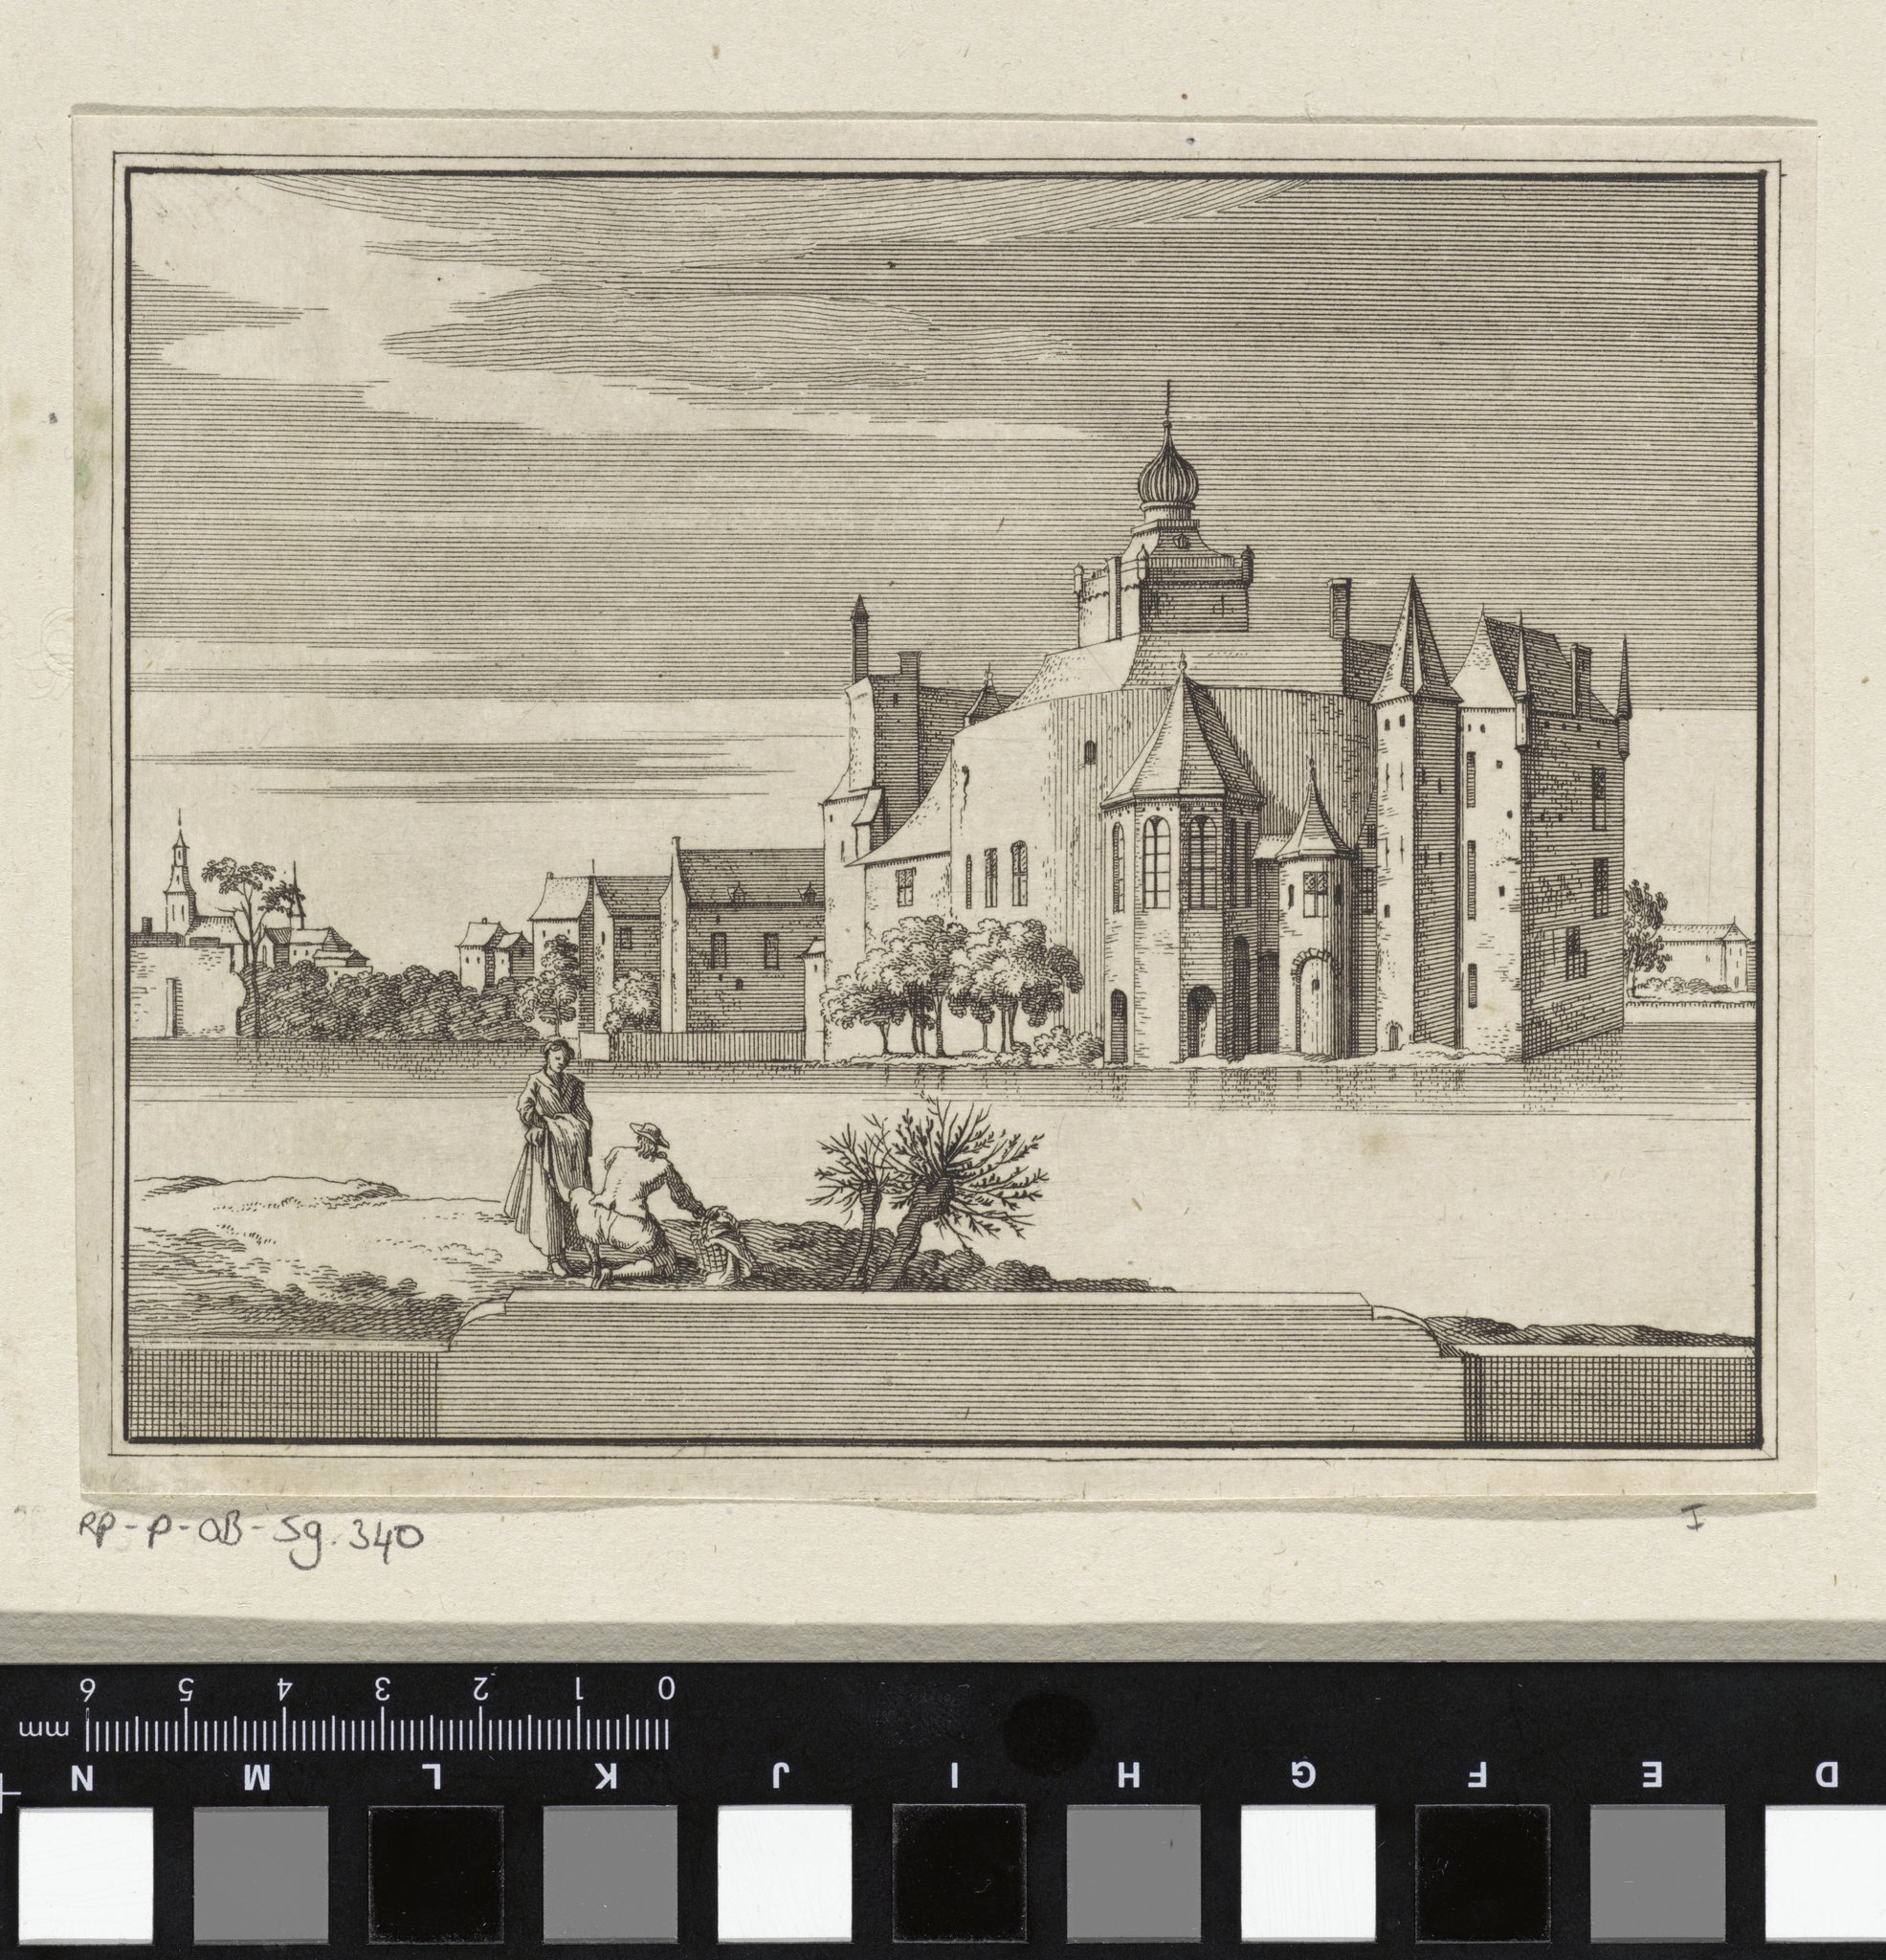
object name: print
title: Gezicht op het kasteel van Montfoort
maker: jacobus schijnvoet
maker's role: draughtsman, print maker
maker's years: 1685-1743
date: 1711-1774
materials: paper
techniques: etching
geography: amsterdam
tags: castle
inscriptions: collector's mark: Lugt 2228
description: Latere staat van deze prent als illustratie opgenomen in: Smids, Ludolph. Schatkamer der Nederlandsse[!] oudheden; of Woordenboek, behelsende Nederlands steden, Amsterdam: Pieter de Coup, 1711. Verscheen tevens in de heruitgave van voorgenoemd werk in 1737 en 1774. In 1721 verscheen er een uitgave met alleen de prenten: Nederlandsche oudheden, bestaande in zestig verbeeldingen (...) gelegen in Holland, 't Sticht van Utrecht en Gelderland enz. Amsterdam: Hendrik Bosch, 1721.